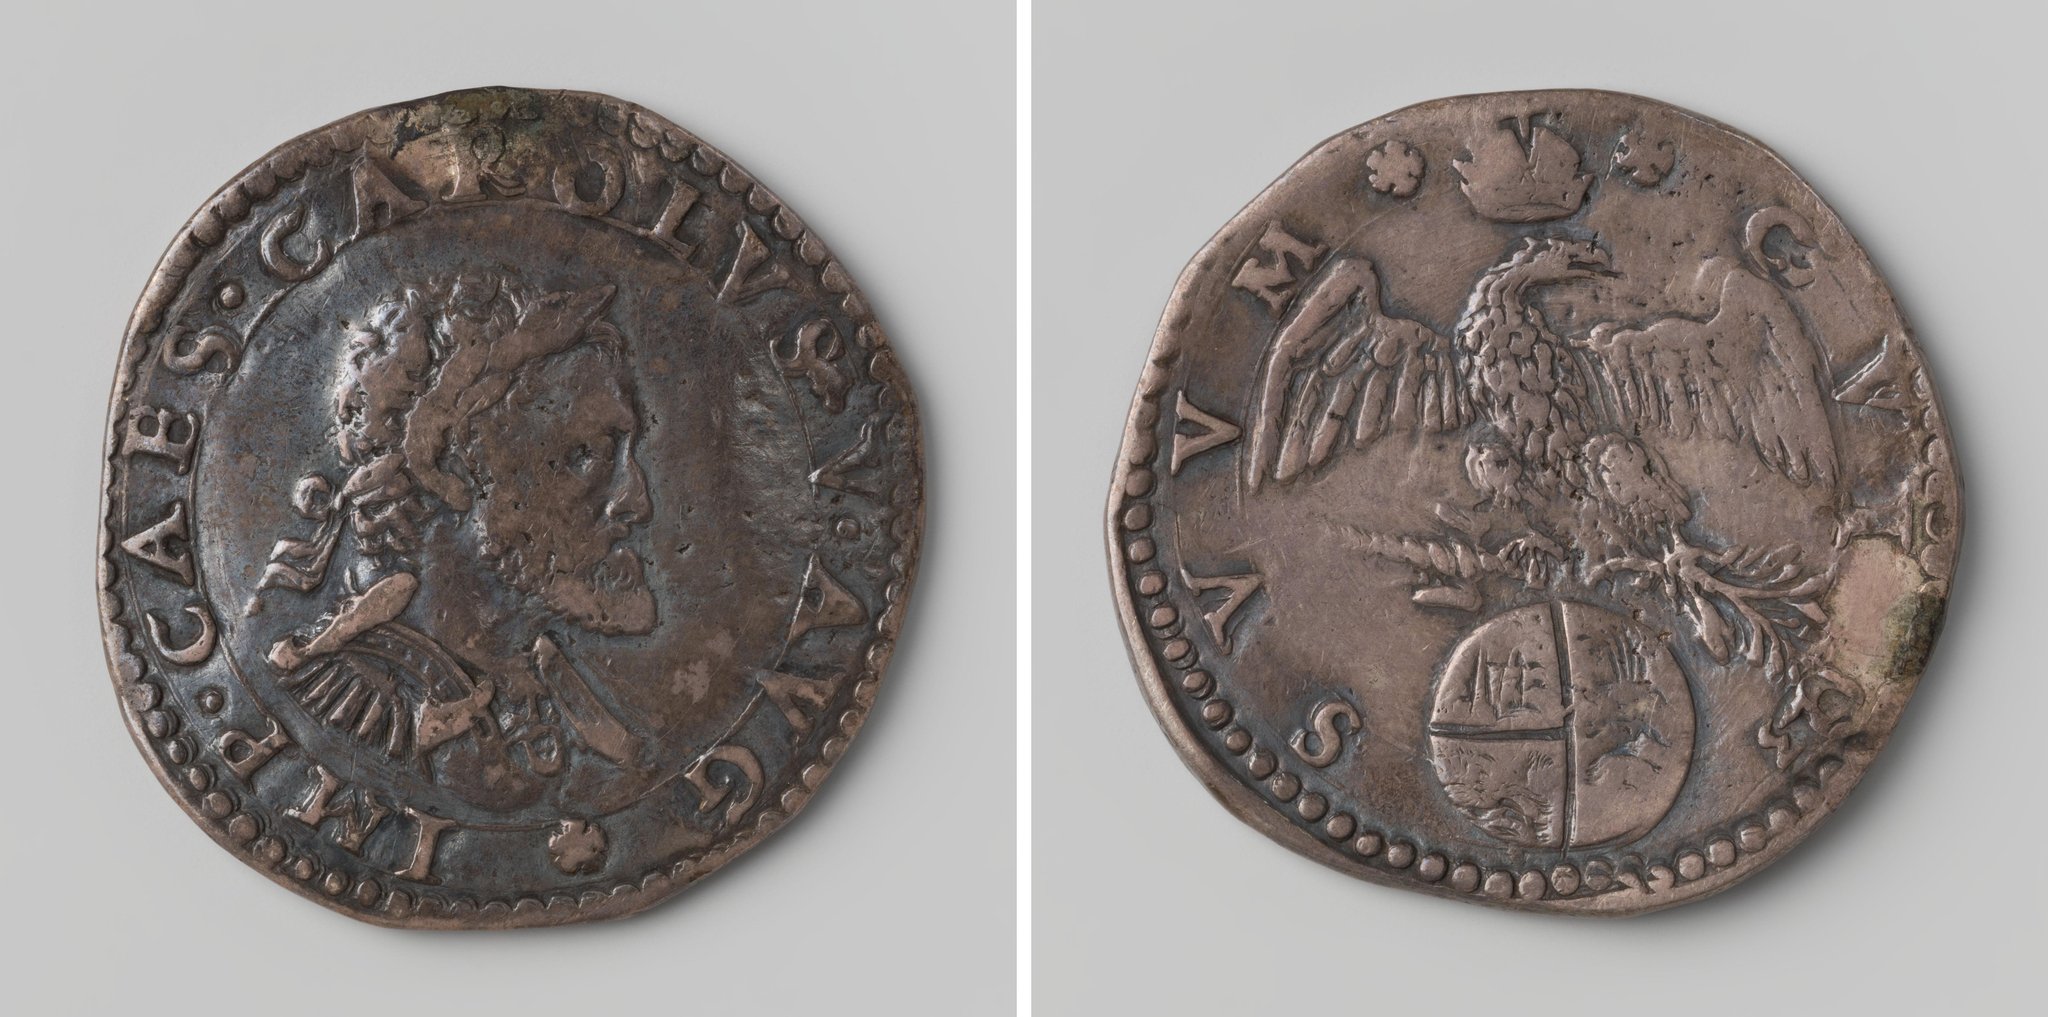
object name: history medal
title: Karel V, Duits keizer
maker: Anonymous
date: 1525-1558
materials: silver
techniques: casting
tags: ghent, charles v (holy roman emperor and king of spain)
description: Zilveren penning. Voorzijde: borststuk man met lauwerkrans naar rechts binnen omschrift. Keerzijde: adelaar met tak in klauwen, zwevend boven aardbol binnen omschrift, onderbroken door kroon tussen twee rozetten